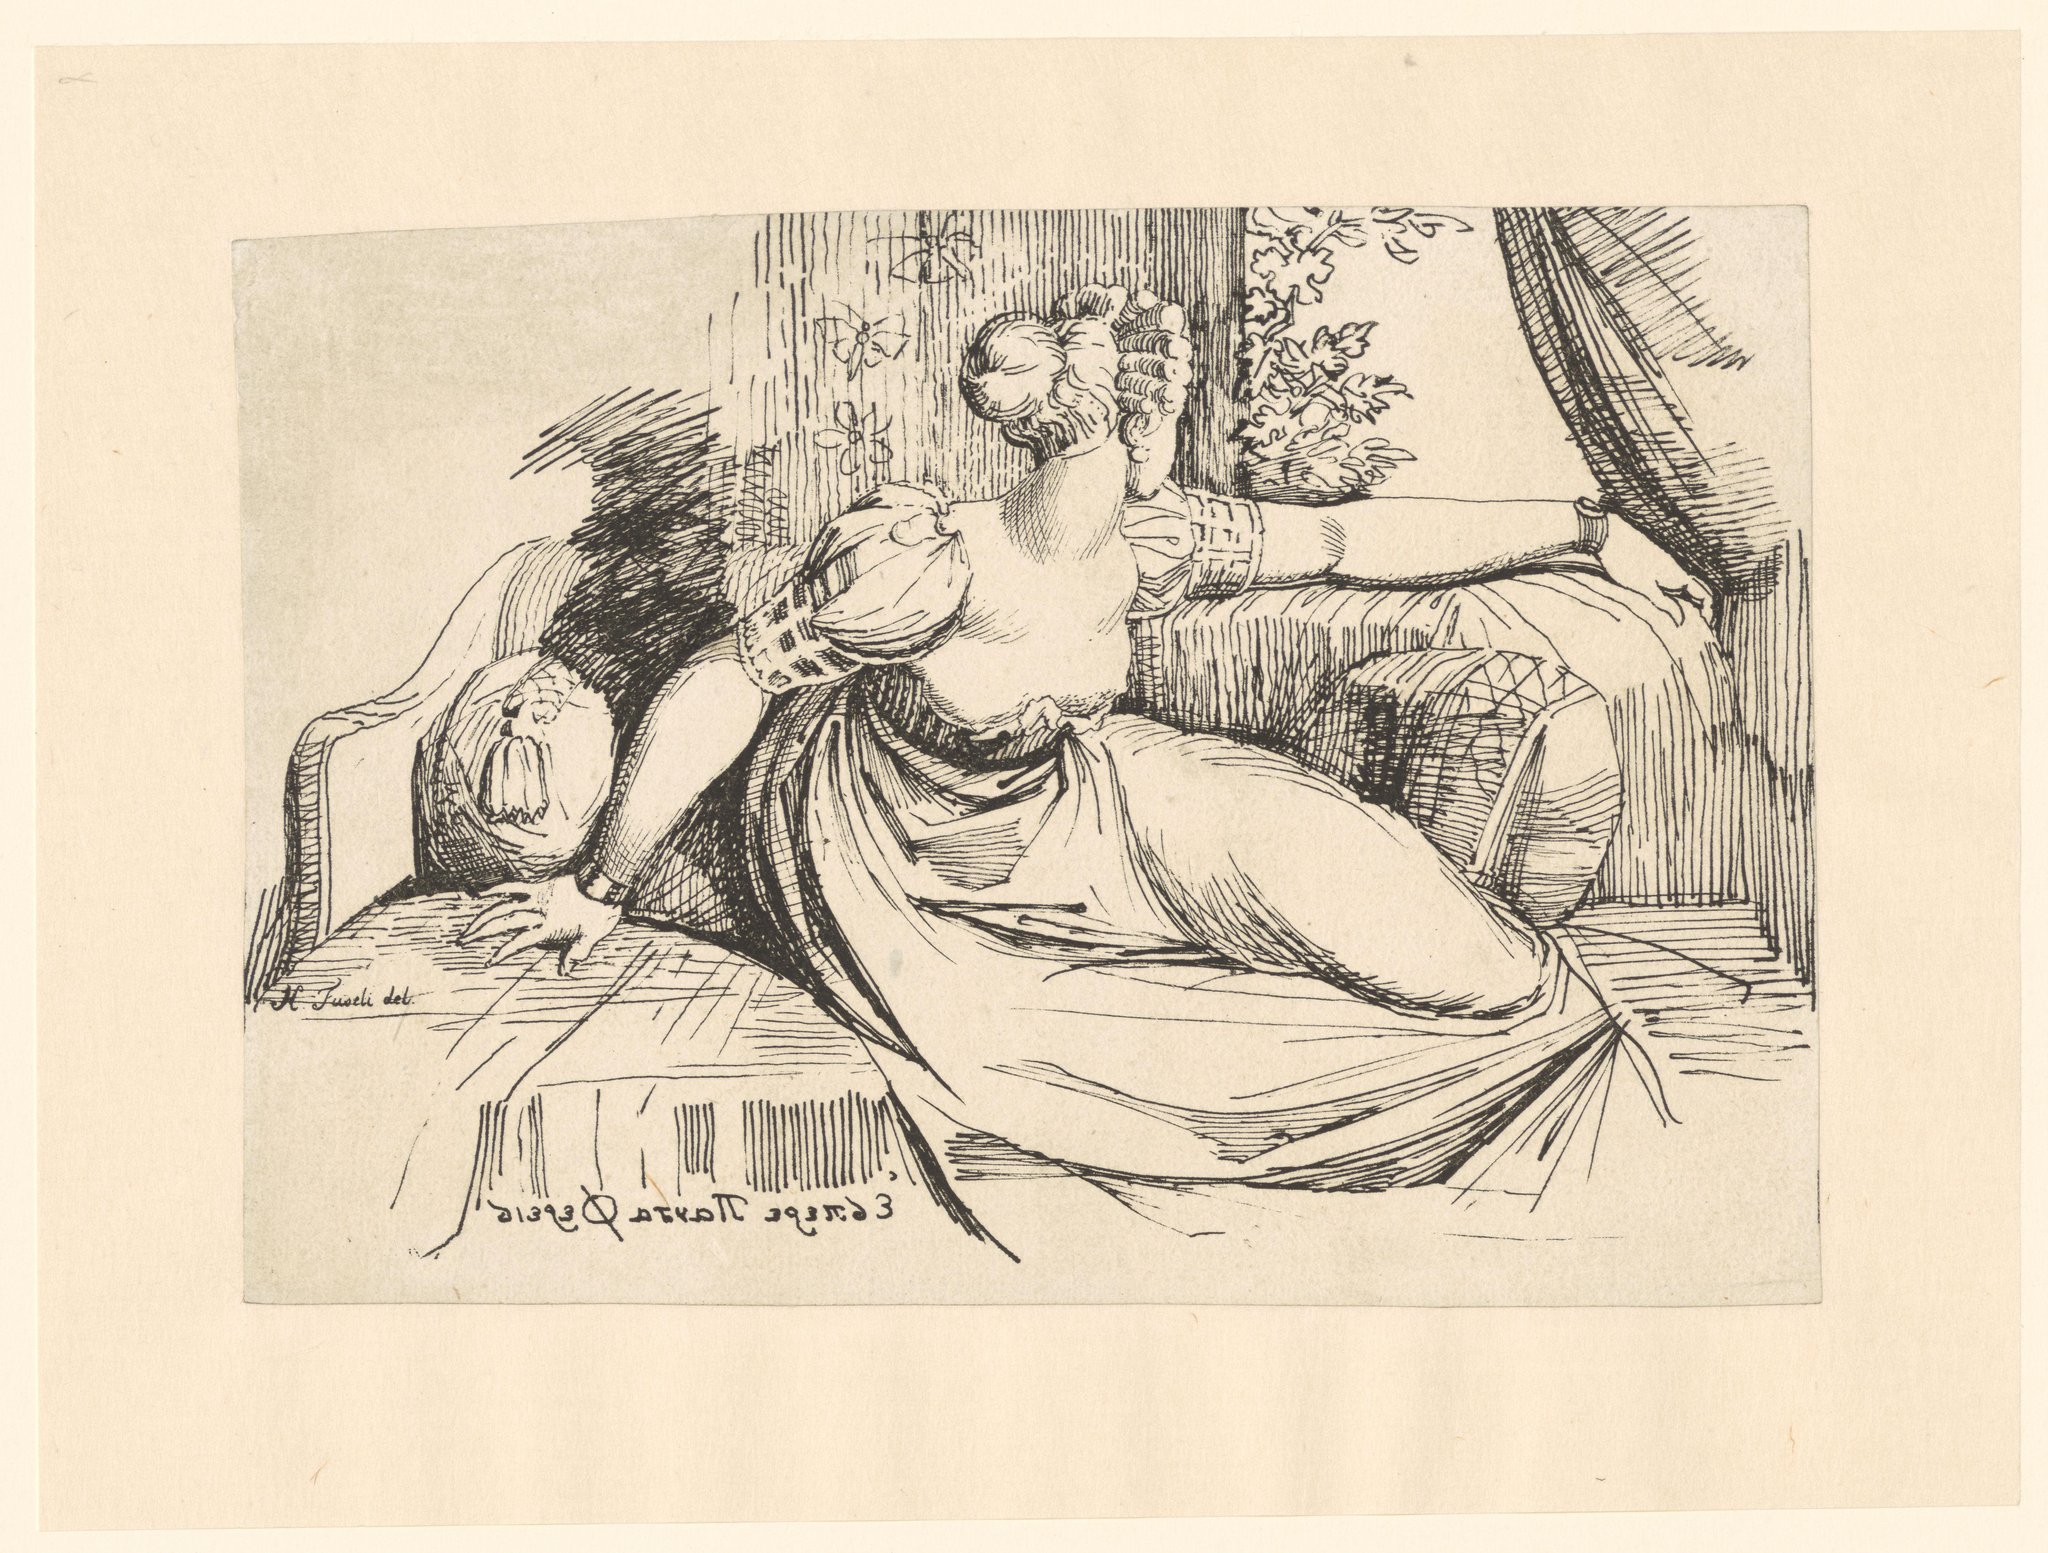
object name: print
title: Vrouw op een rustbed kijkt achterom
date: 1751-1825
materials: paper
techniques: lithograph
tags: adult woman, sitting figure - aa - female human figure, couch, sofa, settee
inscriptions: collector's mark: Lugt 2228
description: Linksonder een tekst in het Grieks in spiegelbeeld: [Hespere panta fereis].